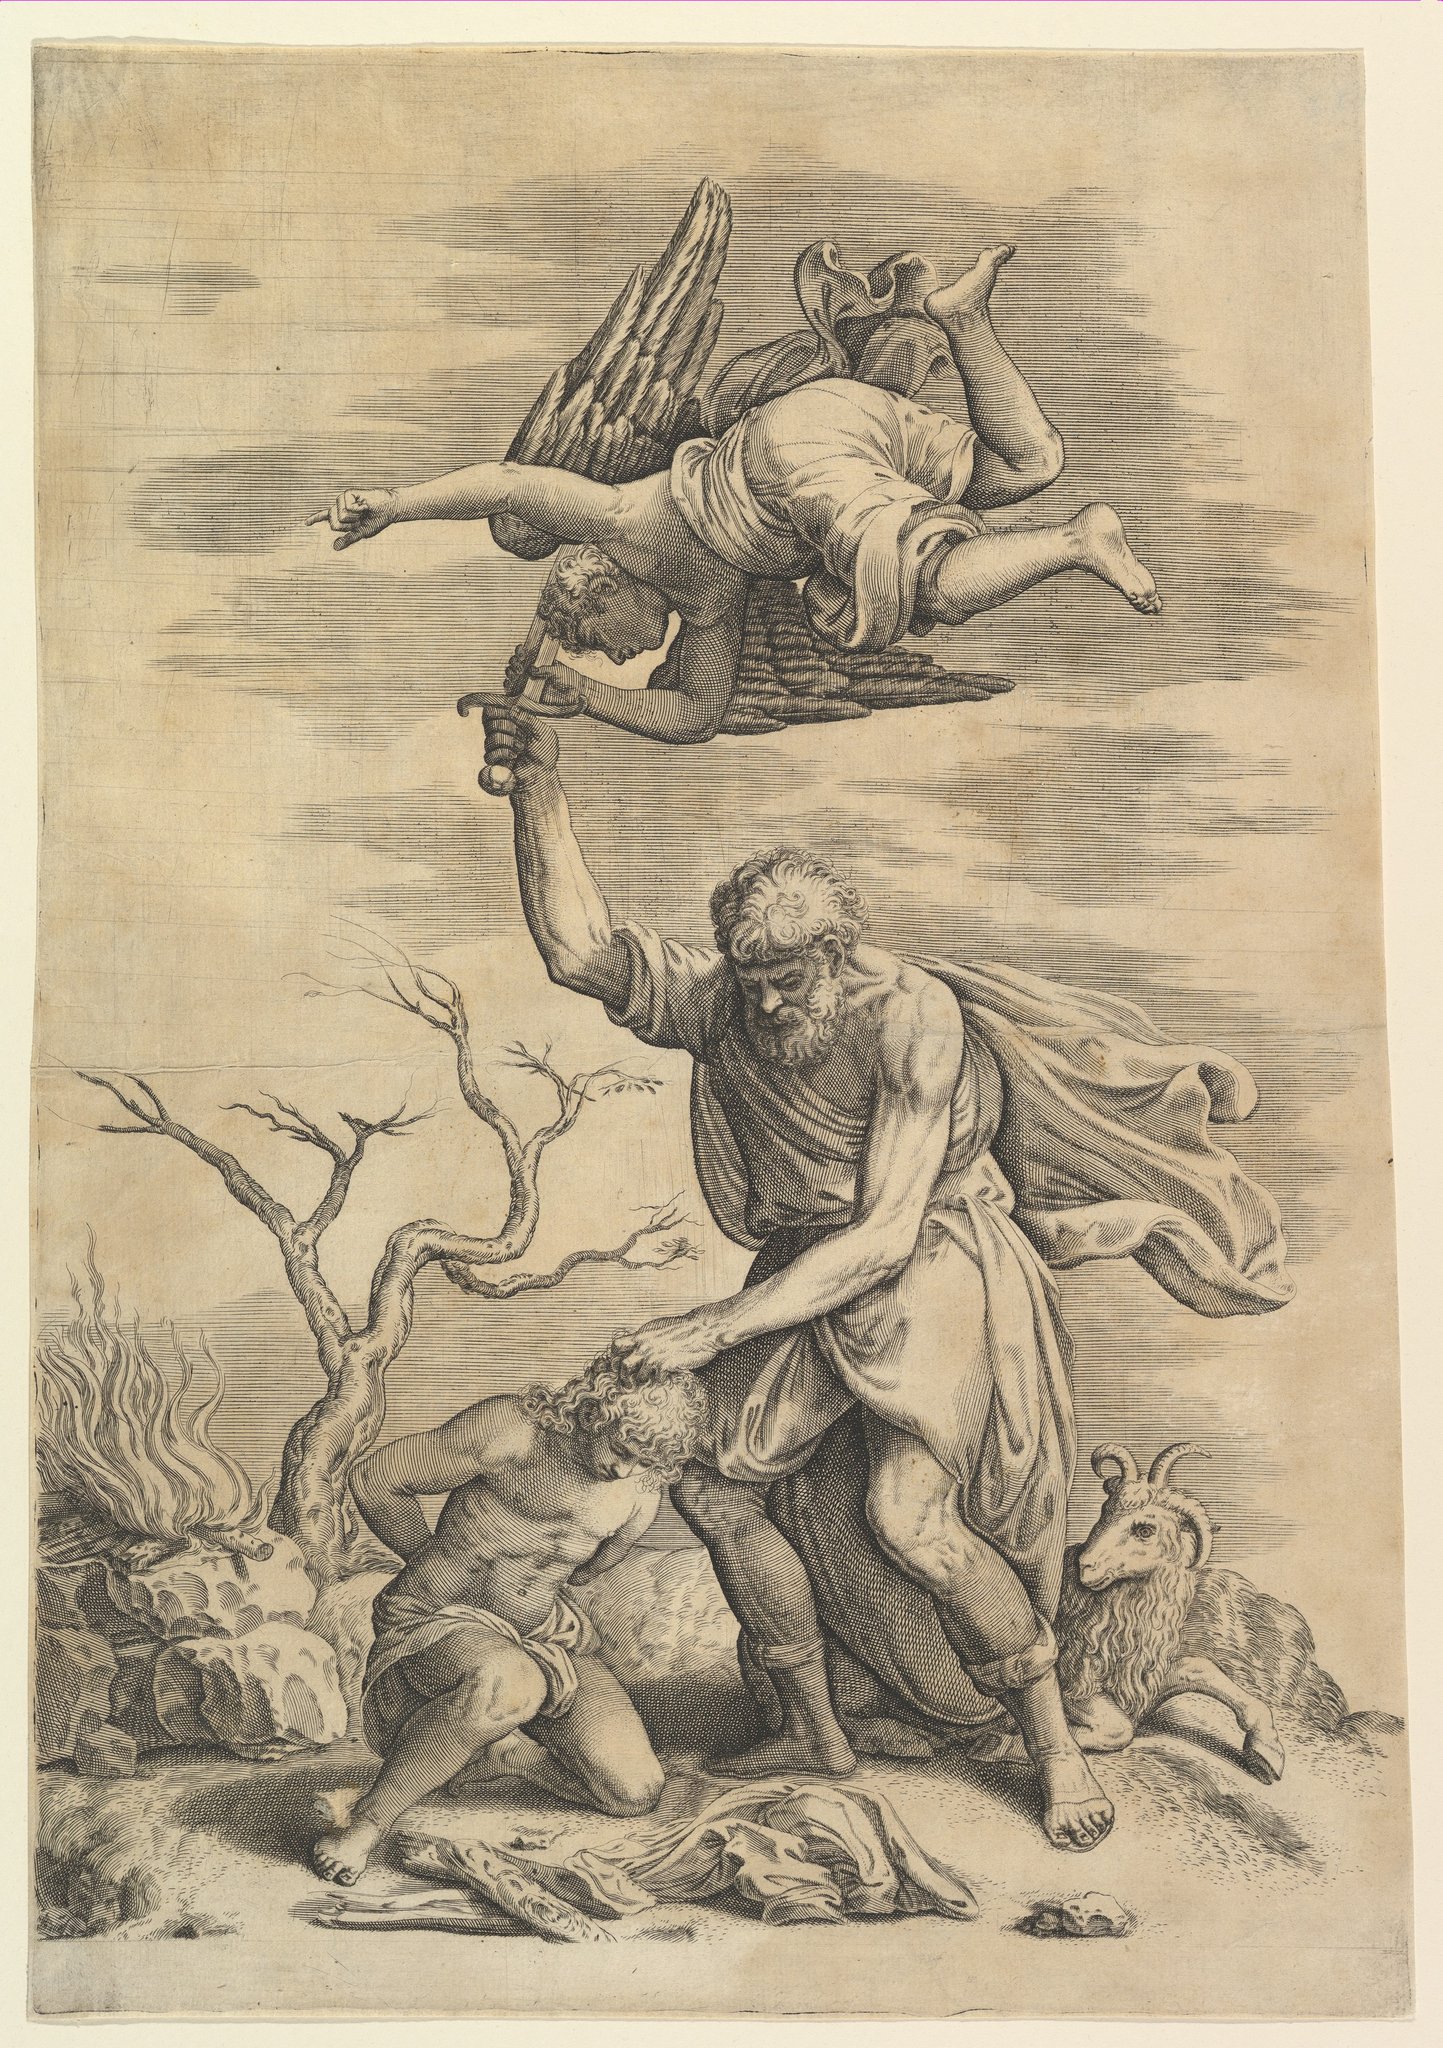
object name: print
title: The sacrifice of Abraham who needs before Isaac who raises his sword to strike him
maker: battista franco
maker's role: artist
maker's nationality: italian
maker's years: 1510-1561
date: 1540-1560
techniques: etching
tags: men,goats,angels,abraham